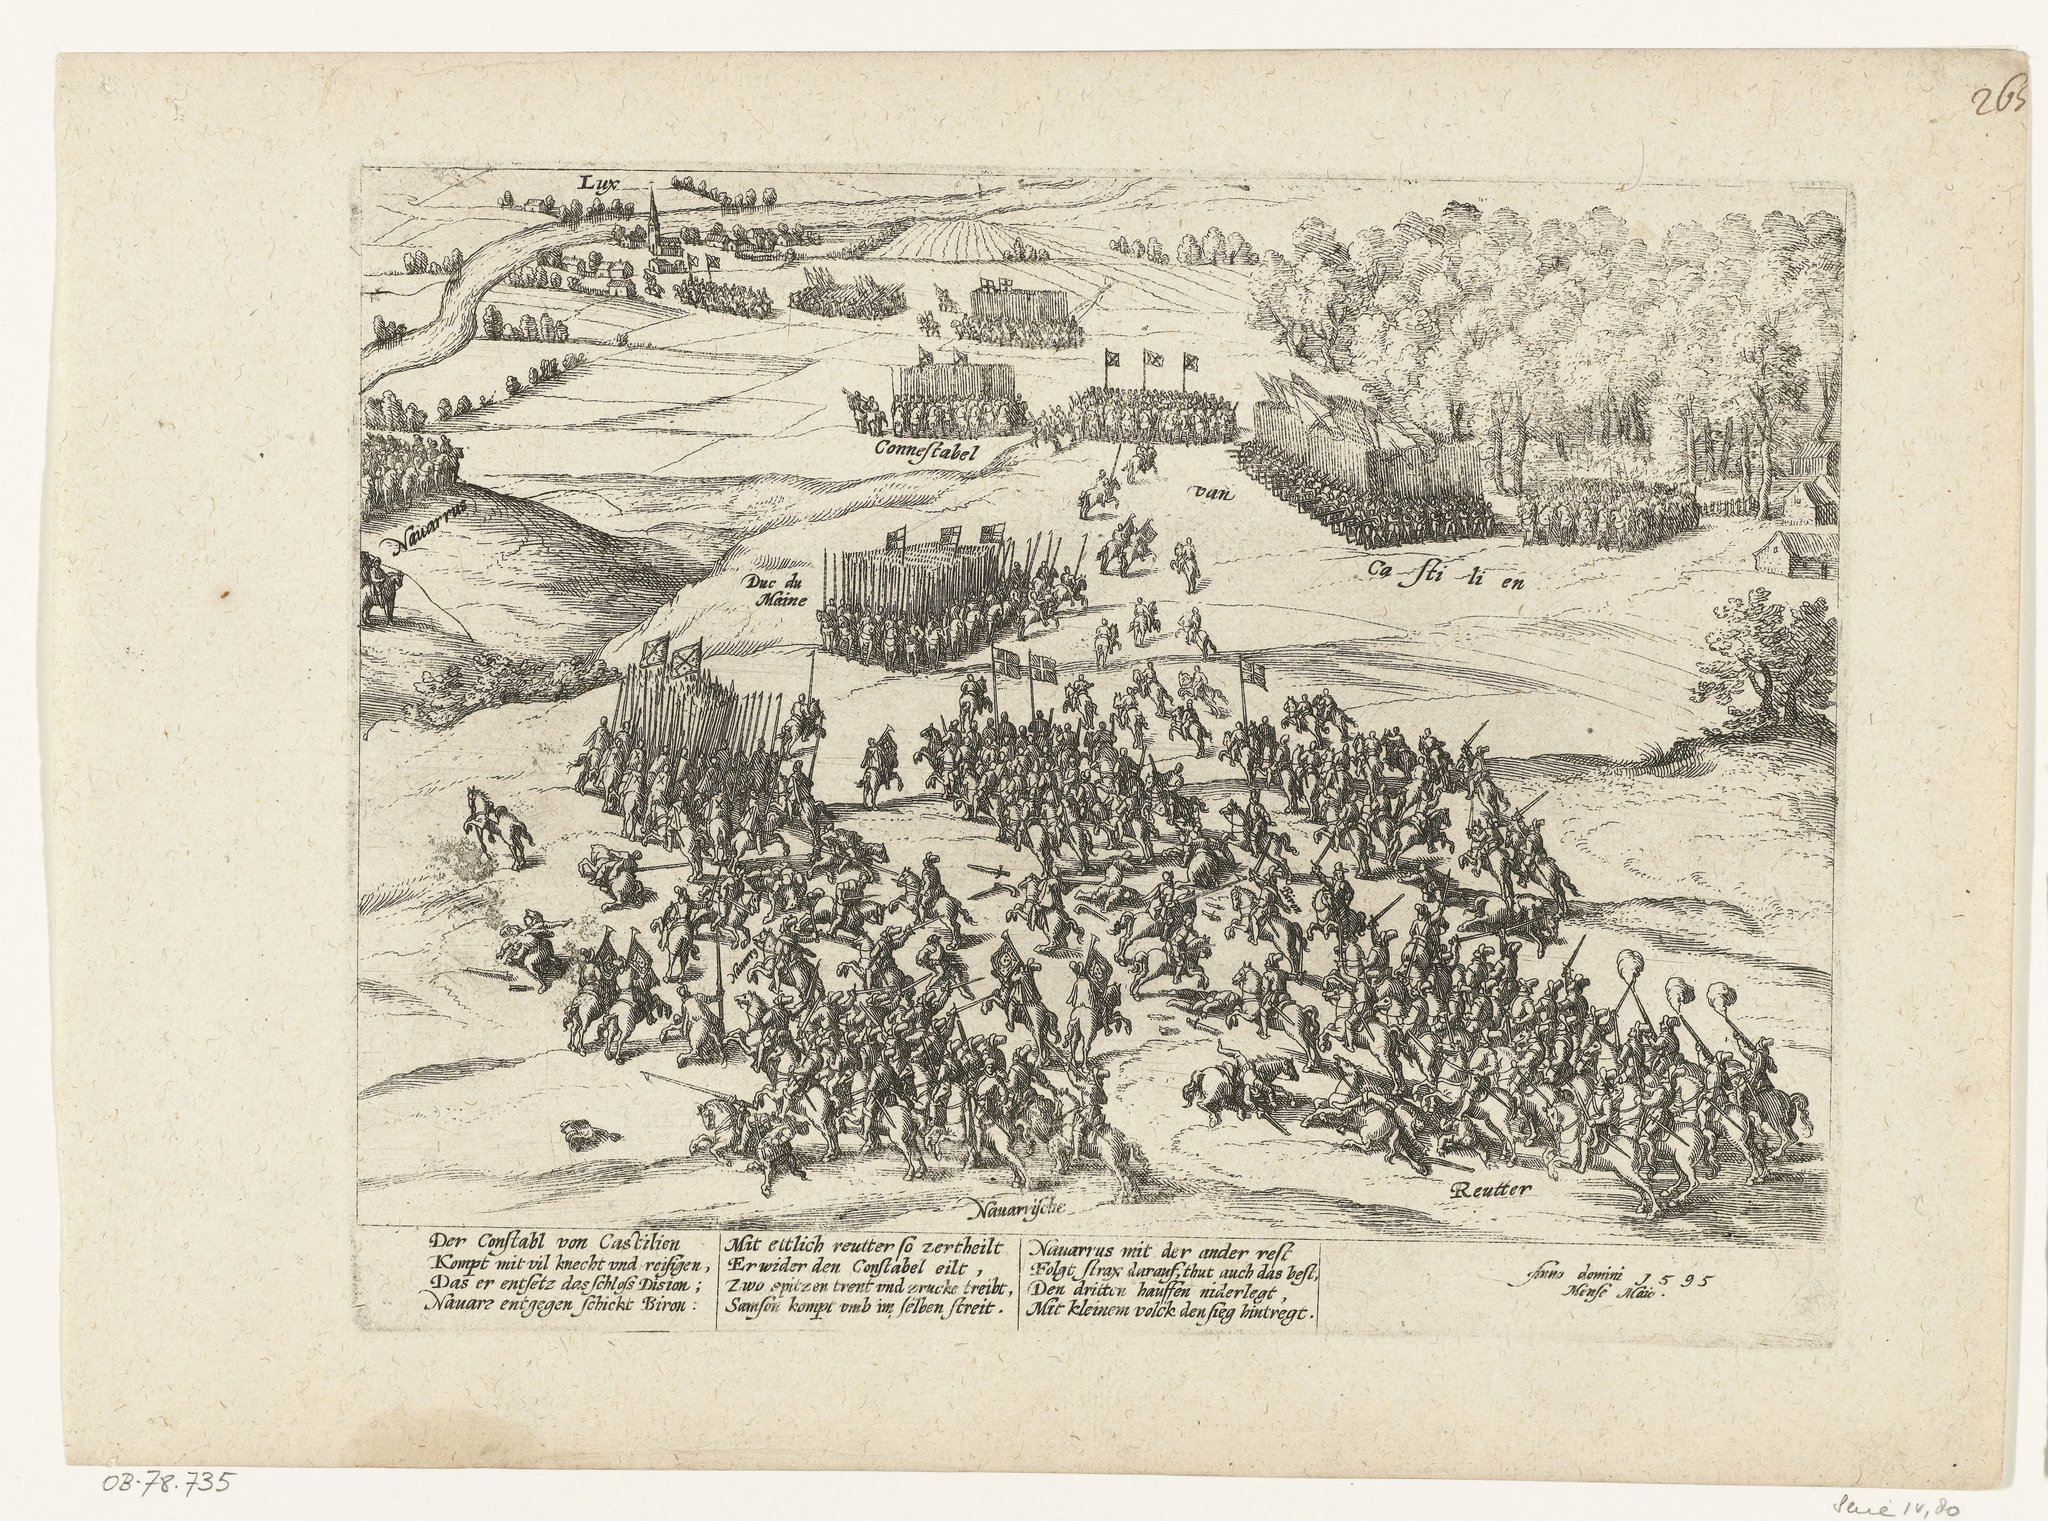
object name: print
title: Serie 4: Franse, Duitse en Engelse Gebeurtenissen, 1576-1610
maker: frans hogenberg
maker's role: print maker, publisher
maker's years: 1538-1590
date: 1595-1597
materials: paper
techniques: etching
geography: cologne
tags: paris, hendrik iv (koning van frankrijk en navarra), battle, fighting in general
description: Overwinning op de Connétable van Castilië bij Dijon, mei 1595. Op de voorgrond de ruiters van de koning, in de verte de ruiters van de Connétable. Met onderschrift van 12 regels in het Duits. Ongenummerd. Blad afkomstig uit een album dat uit elkaar is gehaald. Rechtsboven genummerd (in pen): 263.